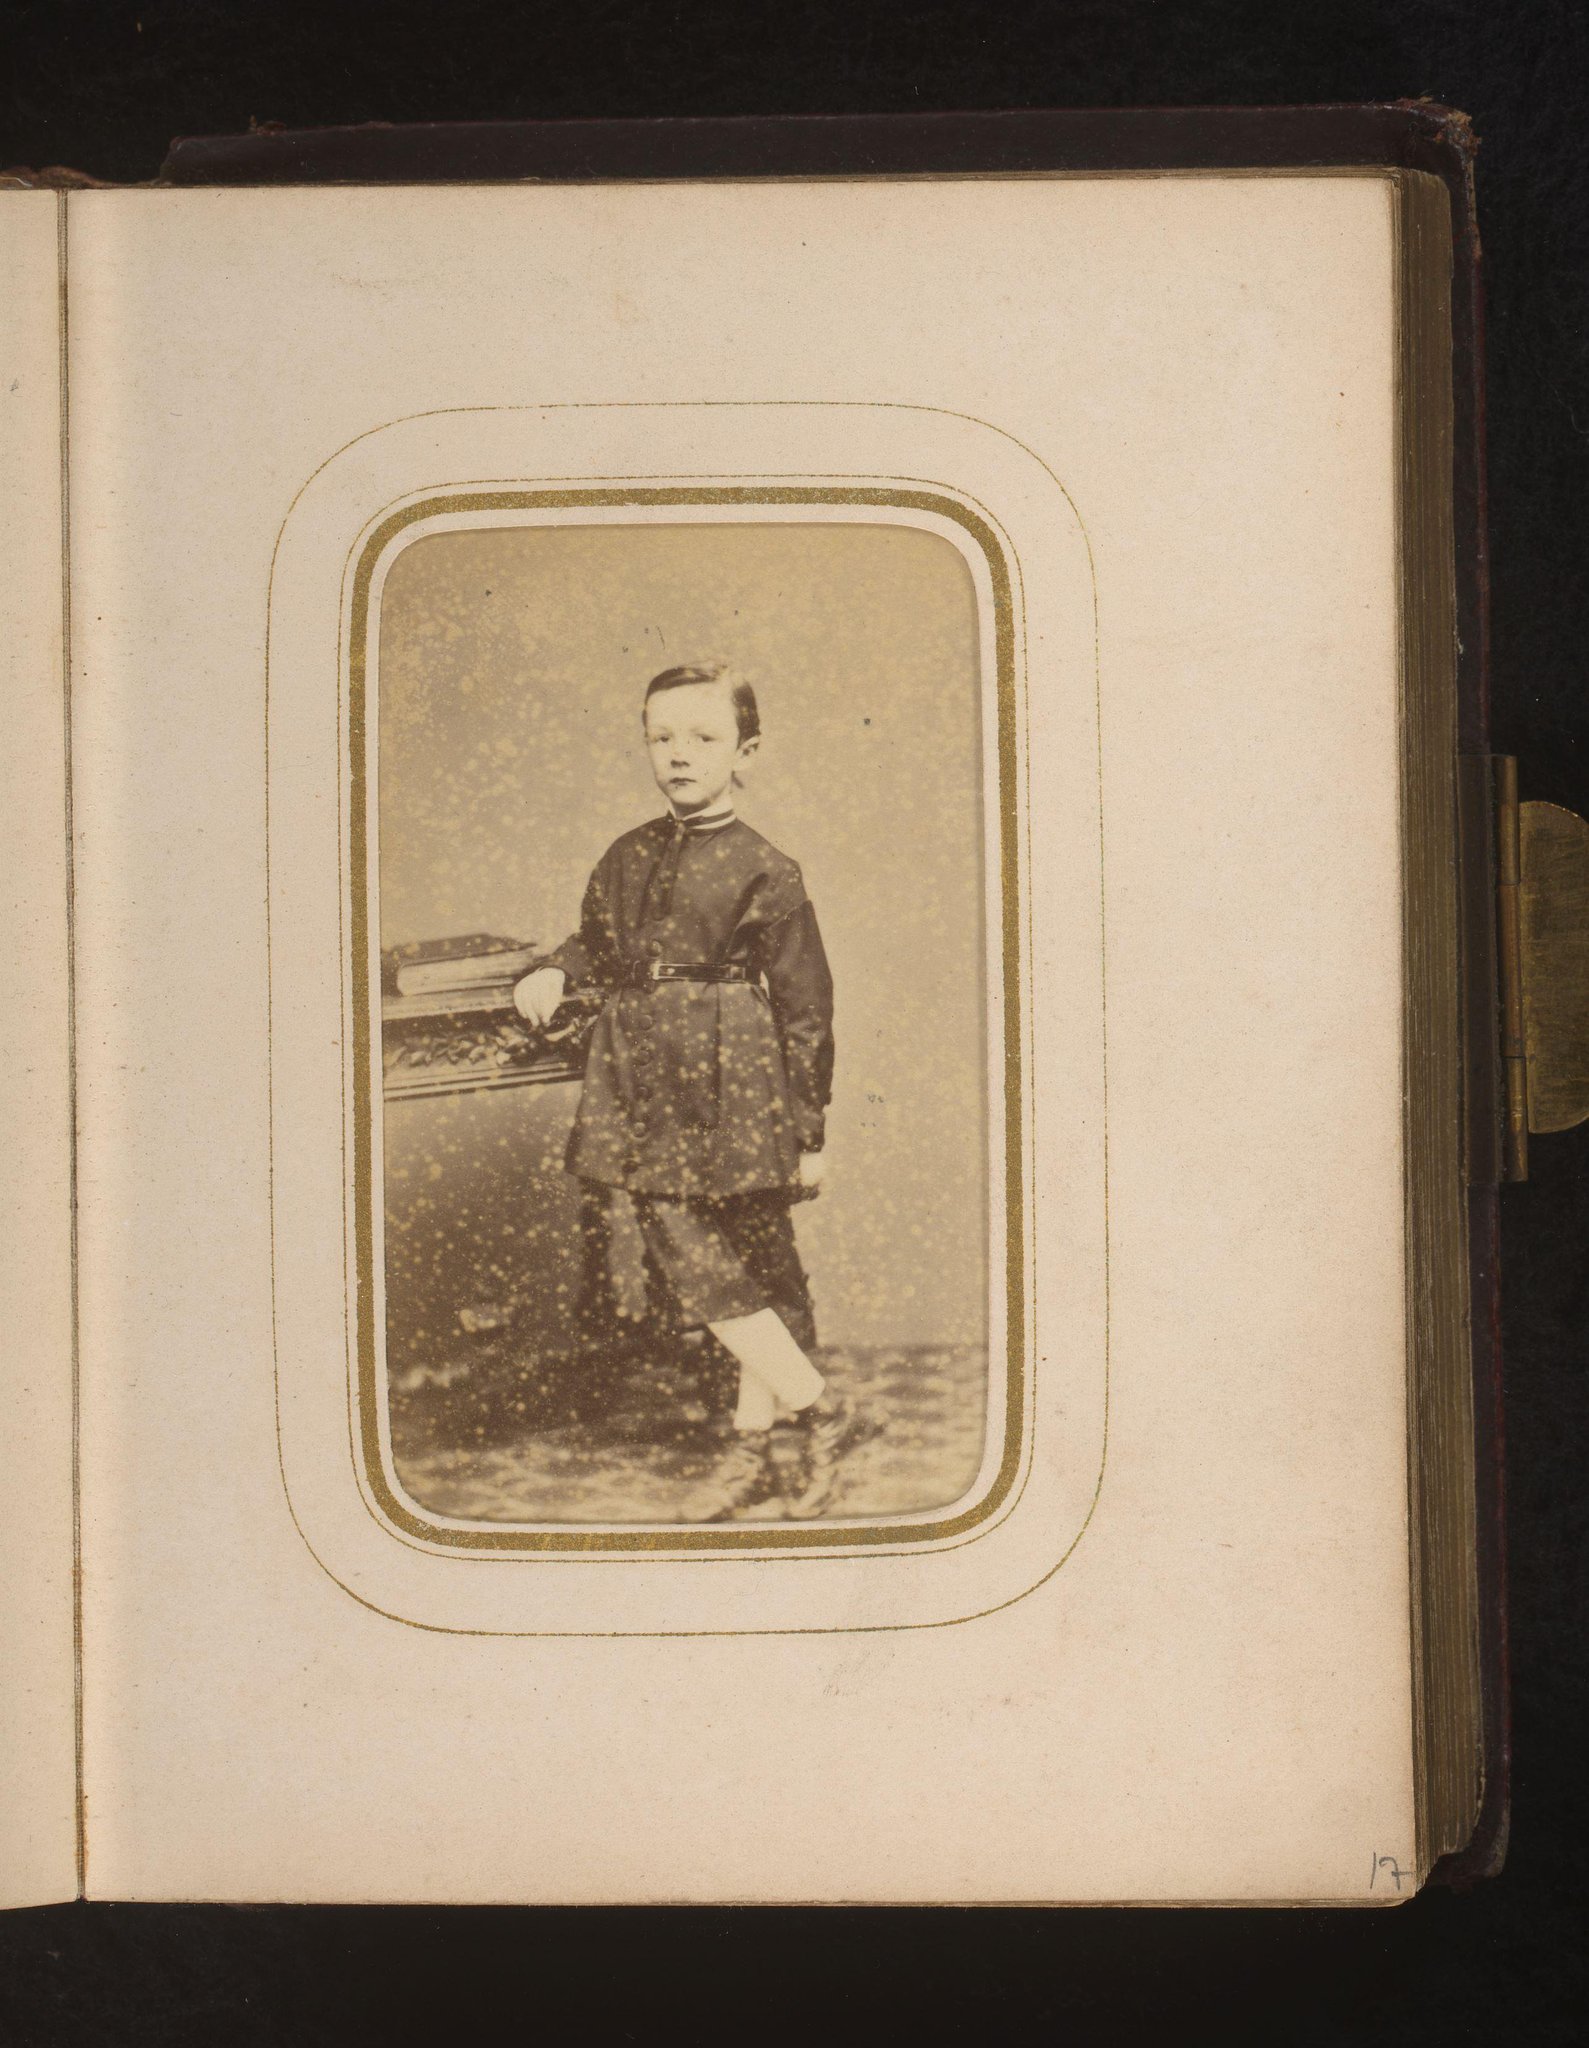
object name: album leaf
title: Portret van een jongen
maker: abel bordéria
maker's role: fotograaf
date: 1860-1900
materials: cardboard, photographic support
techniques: albumen print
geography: reims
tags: boy (child between toddler and youth)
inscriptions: inscription: ‘Bordéria/ Photographe/ Succr. de Muret/ Place Drouet d'Erlon, 6/ près St. Jacques/ Reims’